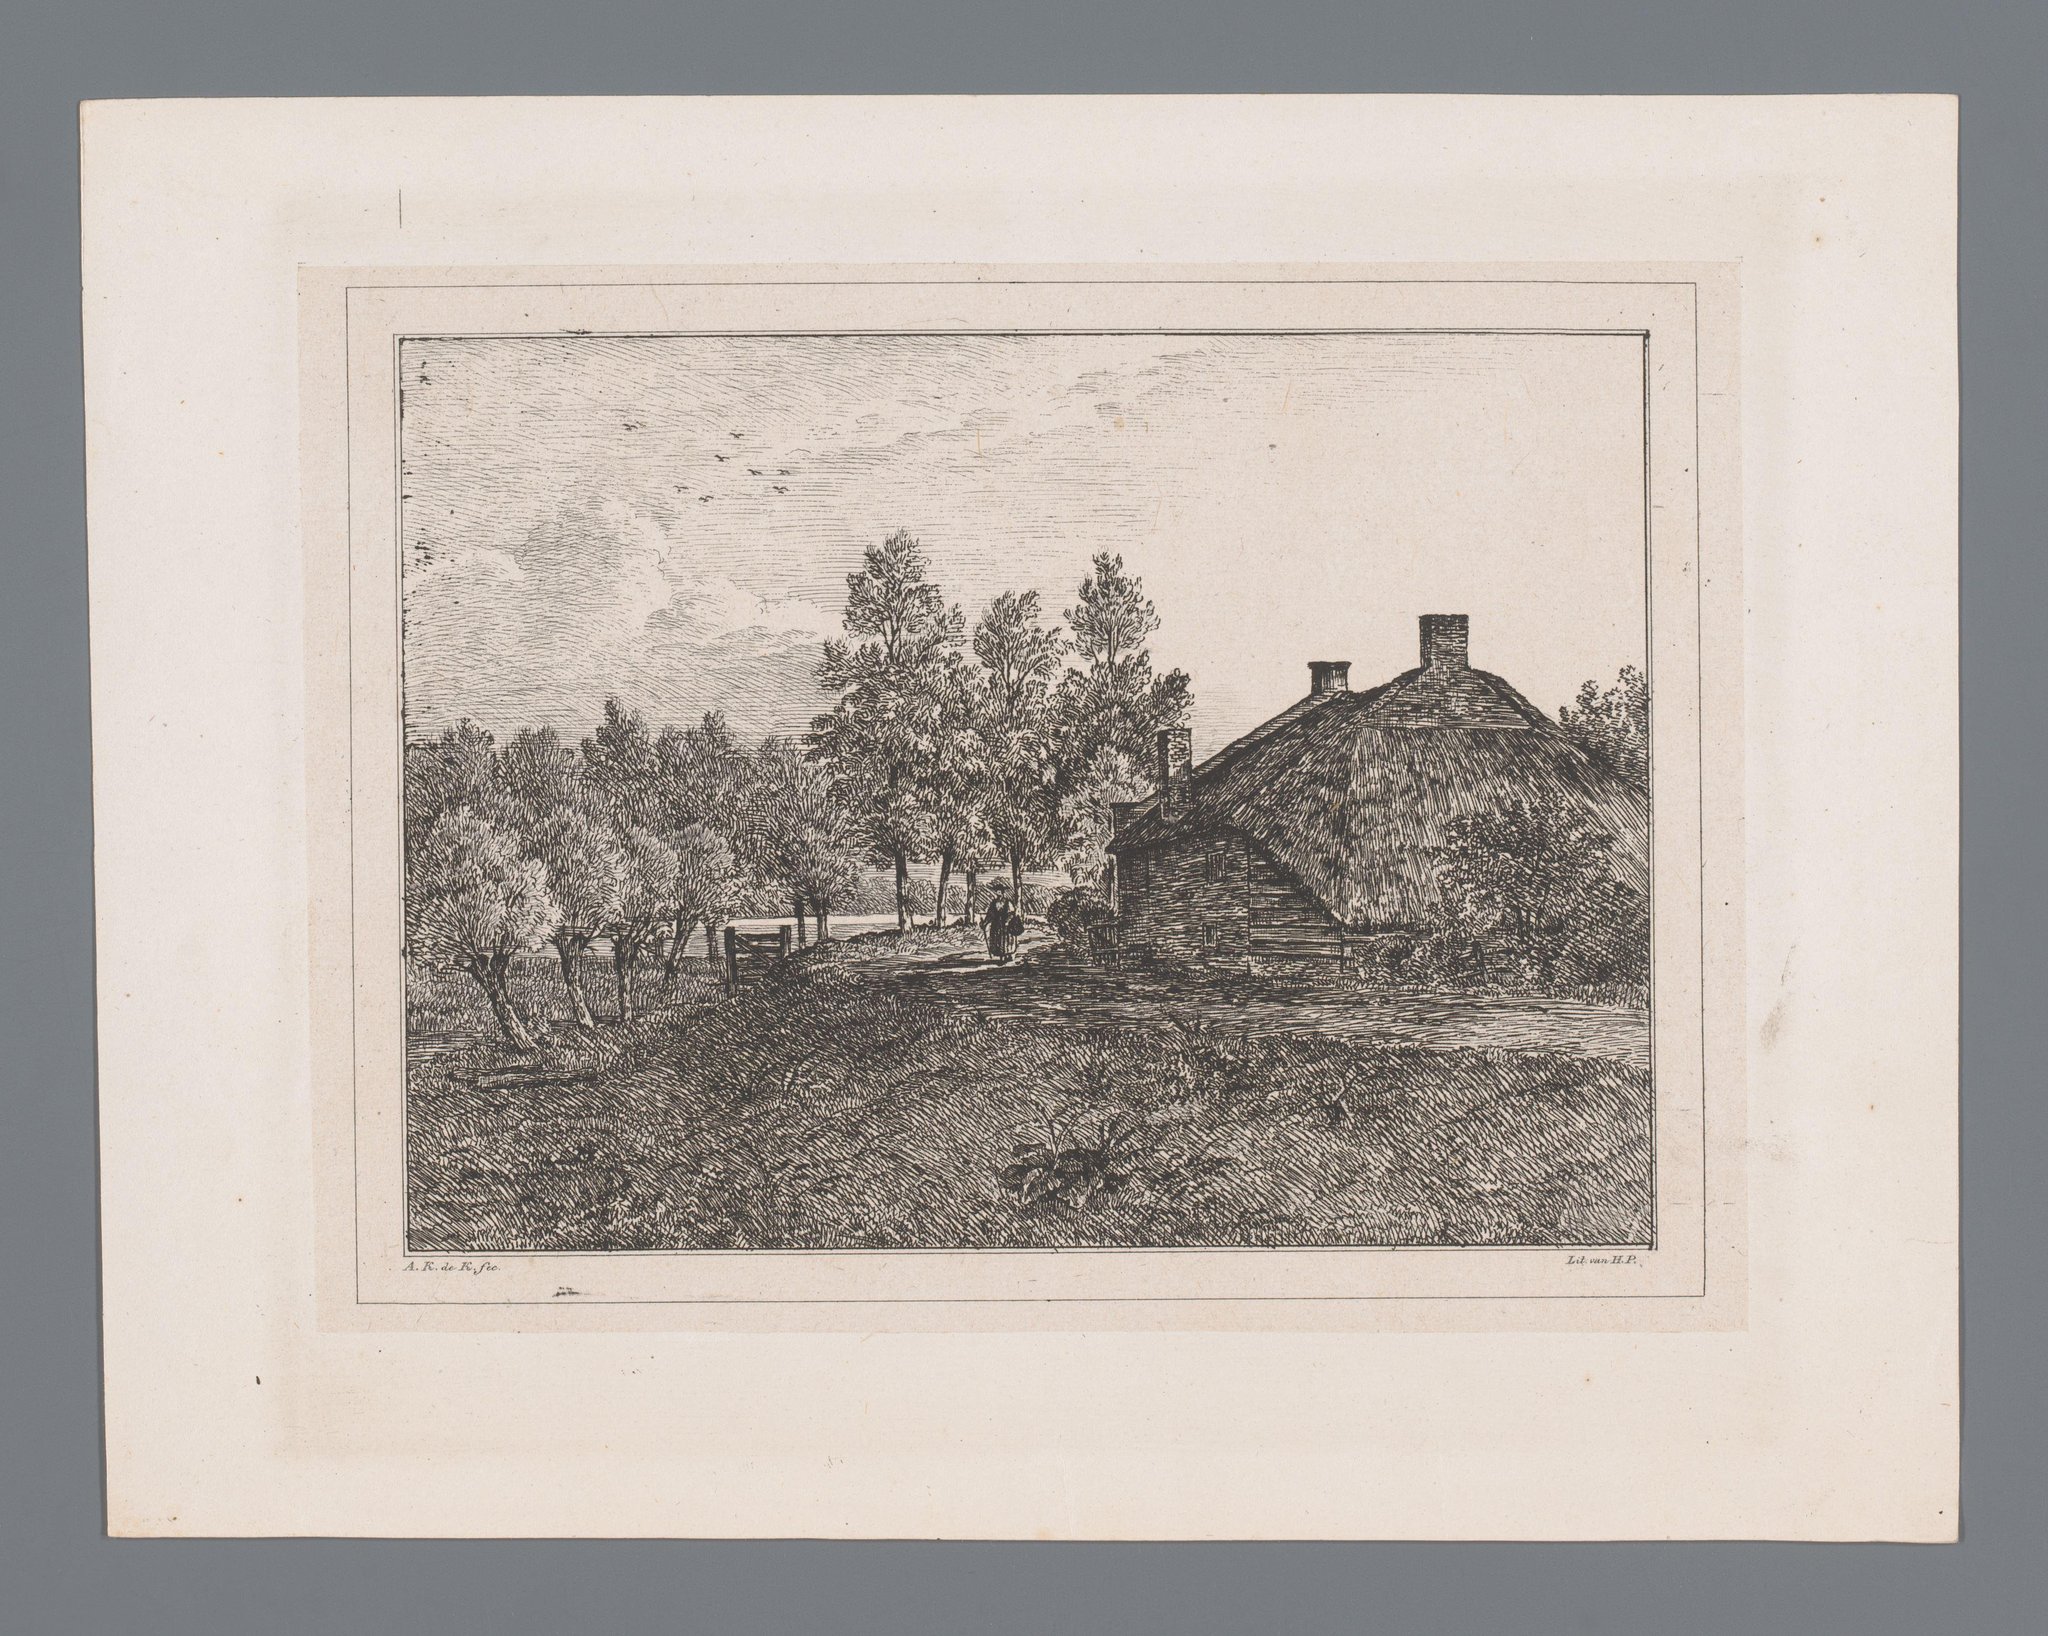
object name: print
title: Boerderij bij Dordrecht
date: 1839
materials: paper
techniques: etching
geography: dordrecht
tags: trees: willow, farm or solitary house in landscape, dordrecht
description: Naast de boerderij loopt een figuur, links een rij knotwilgen.